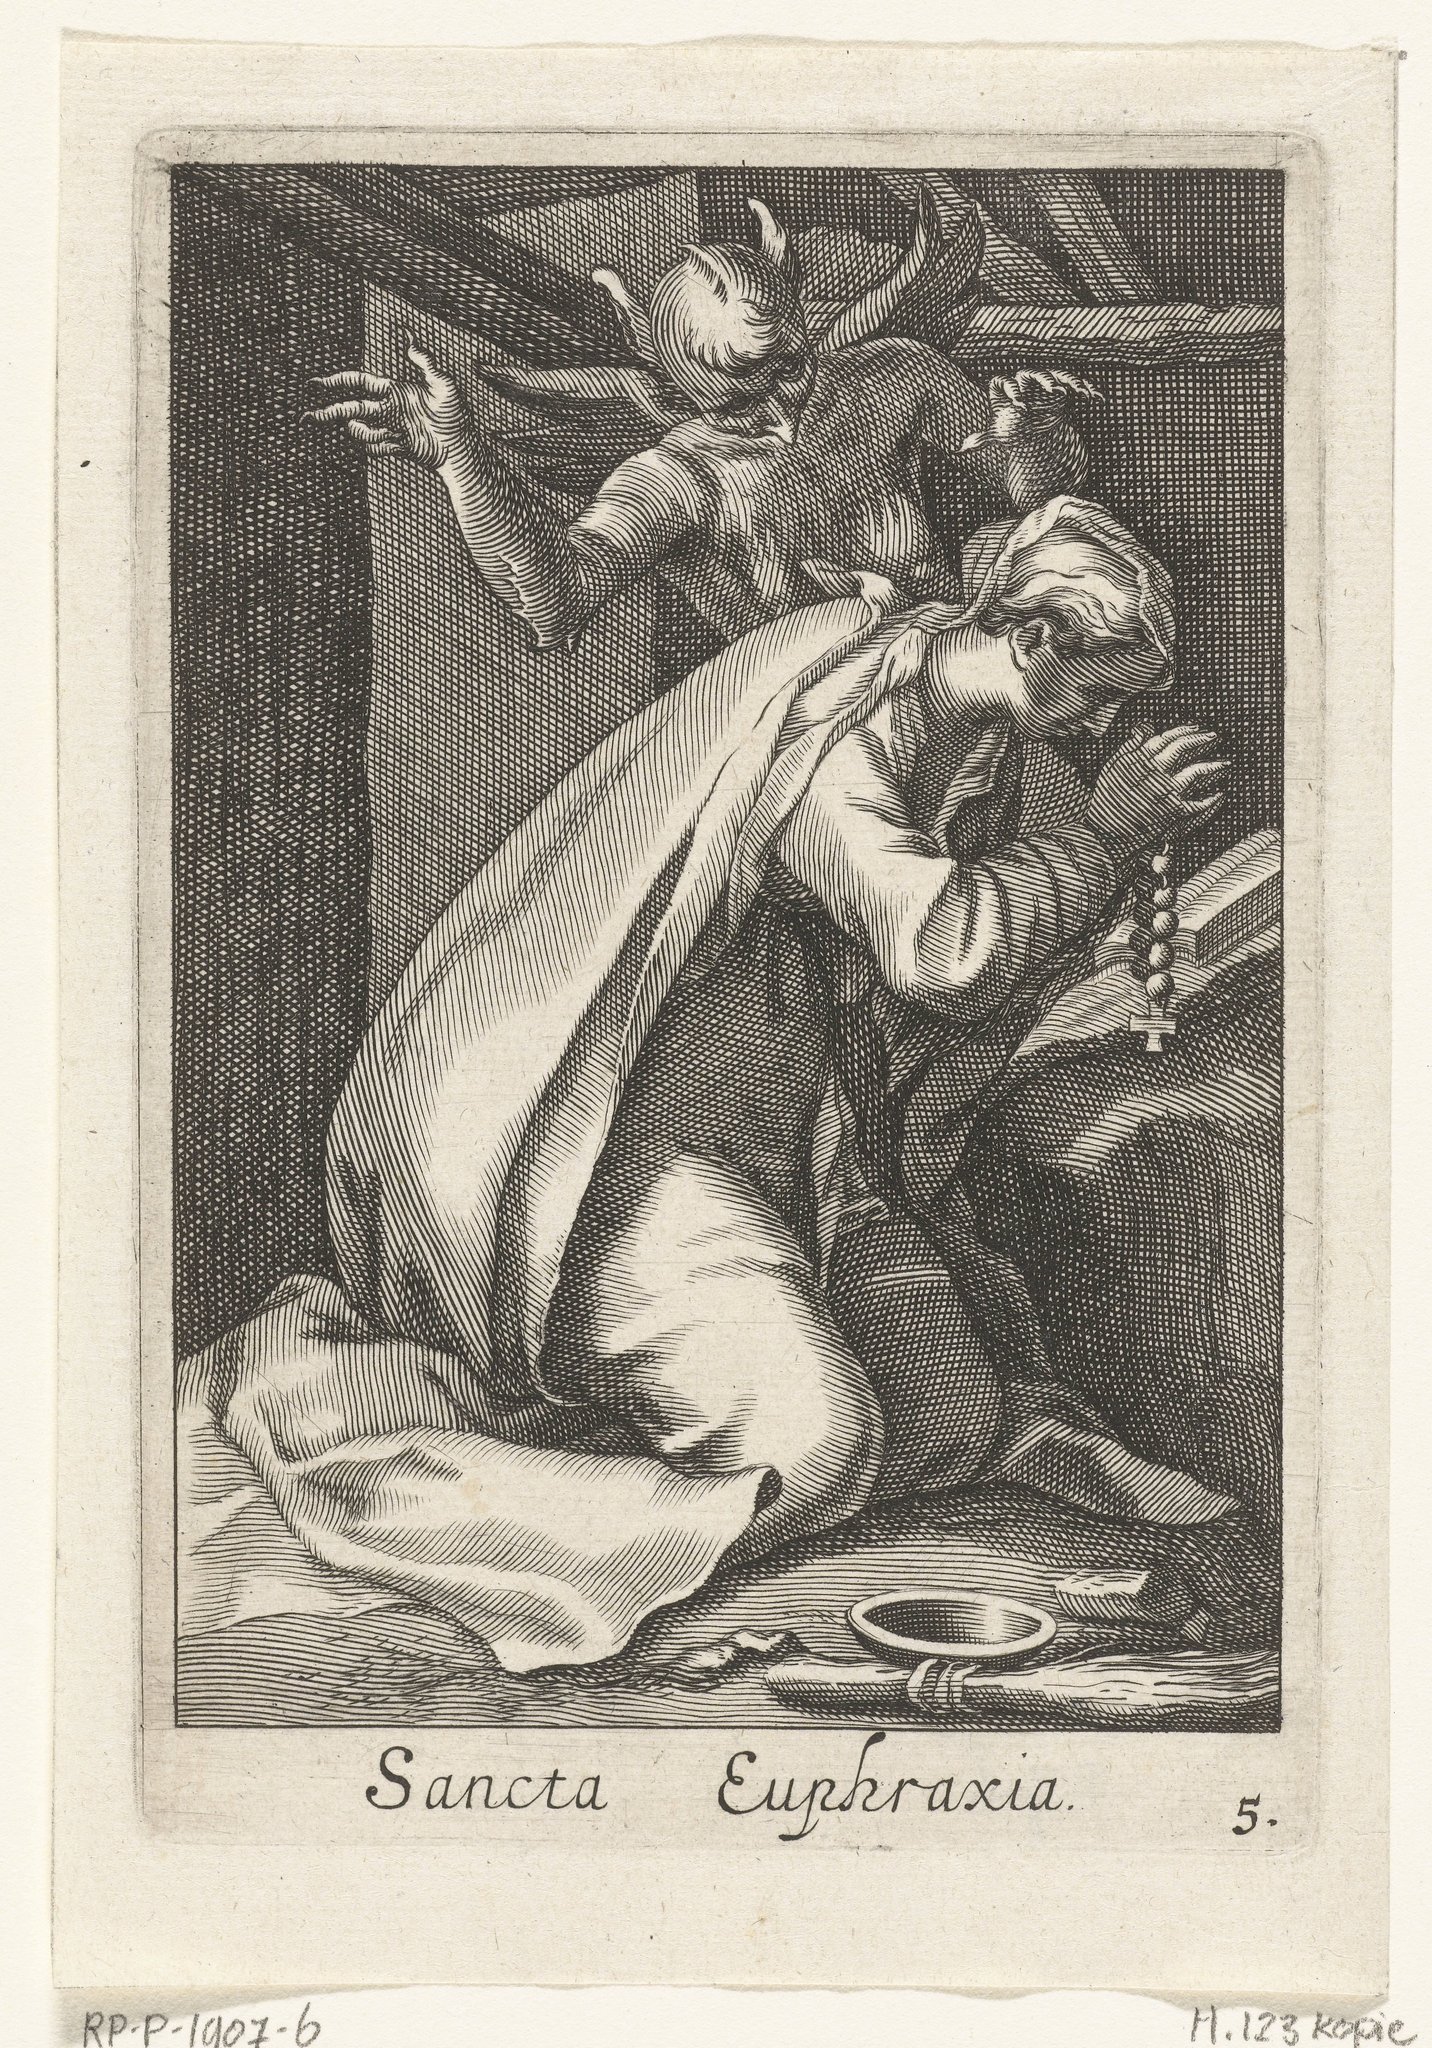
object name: print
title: Sacra Eremus Ascetriarum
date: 1590-1662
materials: paper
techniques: engraving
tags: anchorite, hermit, female saints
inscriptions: collector's mark: Lugt 2228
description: Prent uit: Sacra Eremus Ascetriarum, uitgever Boëtius Adamsz. Bolswert, 1612 of Hendrik Aertssen, Antwerpen 1619. Prent uit de serie van vijfentwintig kluizenaressen in deze uitgaven. In 1612 verscheen een ongebonden editie maar op basis van de gewijzigde opschriften en samenstelling van de serie kluizenaars wordt aangenomen dat de prenten van de uitgave 1619 ook in 1612 of iets daarvoor gedrukt werden. De serie kluizenaressen bleef vrijwel ongewijzigd in de ongebonden uitgave van 1612, dit compliceert de datering van de losse bladen in de collectie van het RMA, zie Roethlisberger 1993, p. 171-175.